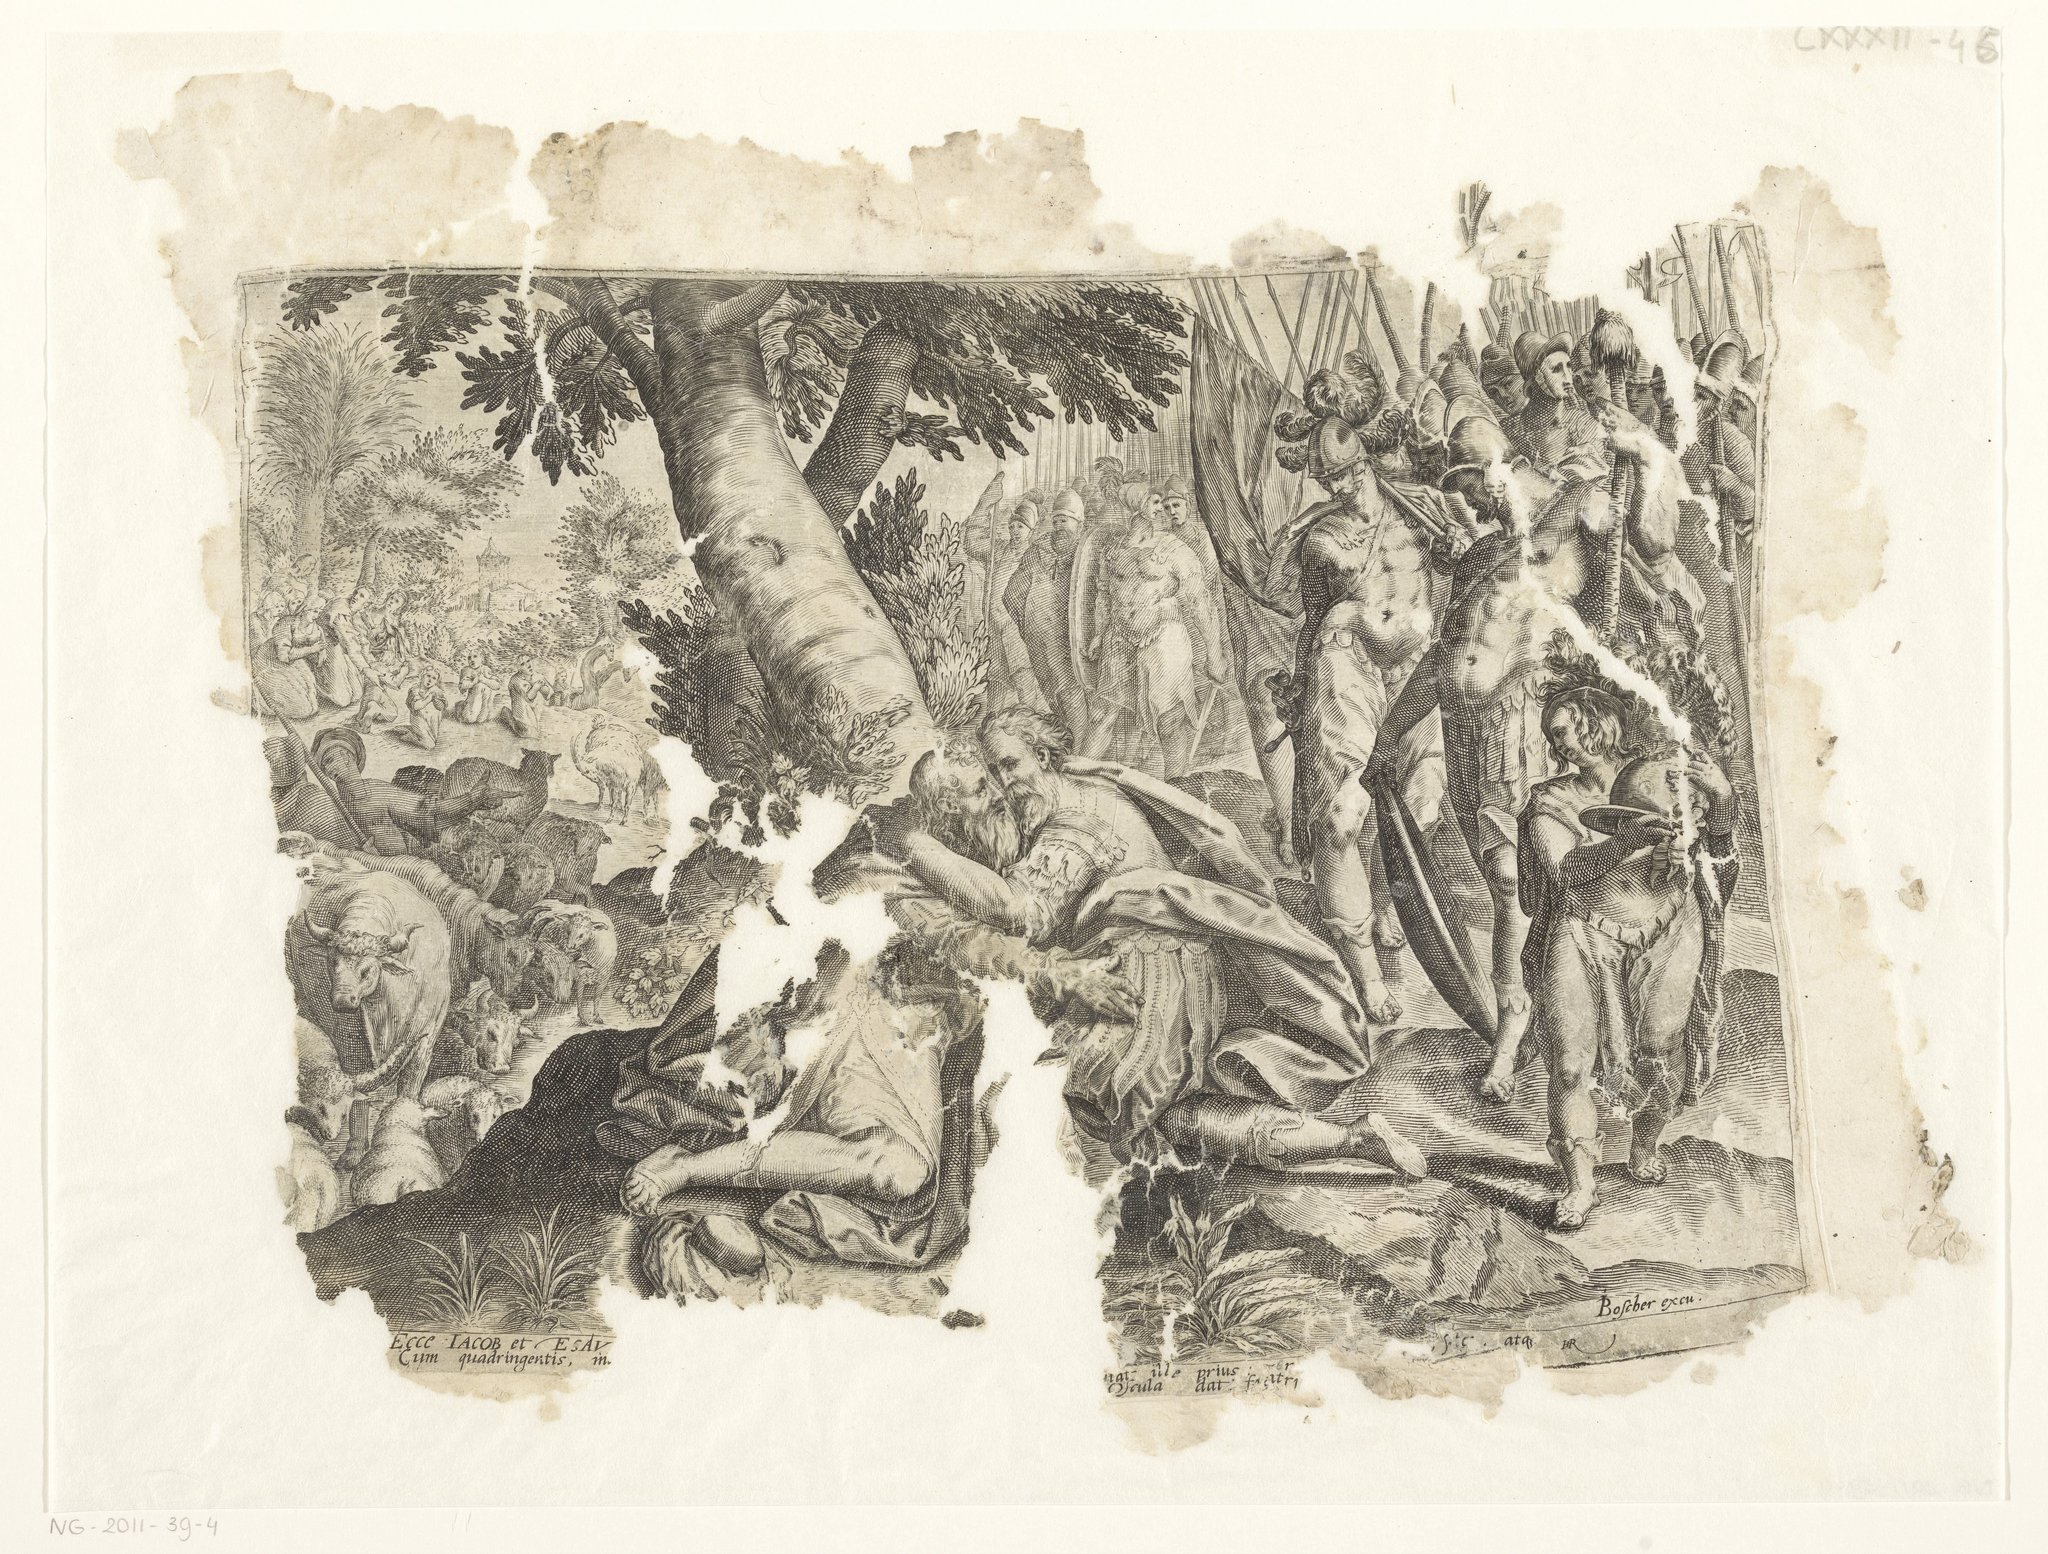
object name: print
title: Verzoening van Jakob en Esau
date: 1580-1596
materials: paper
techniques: engraving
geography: northern netherlands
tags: the meeting between esau and jacob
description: Tot dusverre was deze prent alleen bekend in een latere editie met het adres van C.J. Visscher in het door hem uitgegeven Theatrum Biblicum uit 1643, zie RP-P-1976-30-39. De prenten in de Nova Zembla collectie zijn tijdens een expeditie van Willem Barendsz en Jacob van Heemskerk in 1596-1597 noodgedwongen in het winterkamp, het ‘Behouden Huis’, op het eiland achtergelaten. De prenten waren in één of meerdere stapels als handelswaar meegenomen vanuit Amsterdam. Bijna drie eeuwen later, in 1871, keerde de Noor Elling Carlsen terug naar Nova Zembla en vond daar de restanten van het ‘Behouden Huis, inclusief een groot deel van de inventaris. Een deel van de prenten, in de vorm van aaneengekoekte kluiten, werd toen ook teruggevonden. De papierkluiten waren soms op meerdere plekken gebroken. Tussen 1975-1979 zijn de prenten van elkaar gescheiden. Dit leverde in totaal ca. 1000 fragmenten van ca. 400 afdrukken van ca. 150 verschillende prenten op. Voor zover mogelijk zijn de fragmenten samengevoegd en zijn de prenten gereconstrueerd.